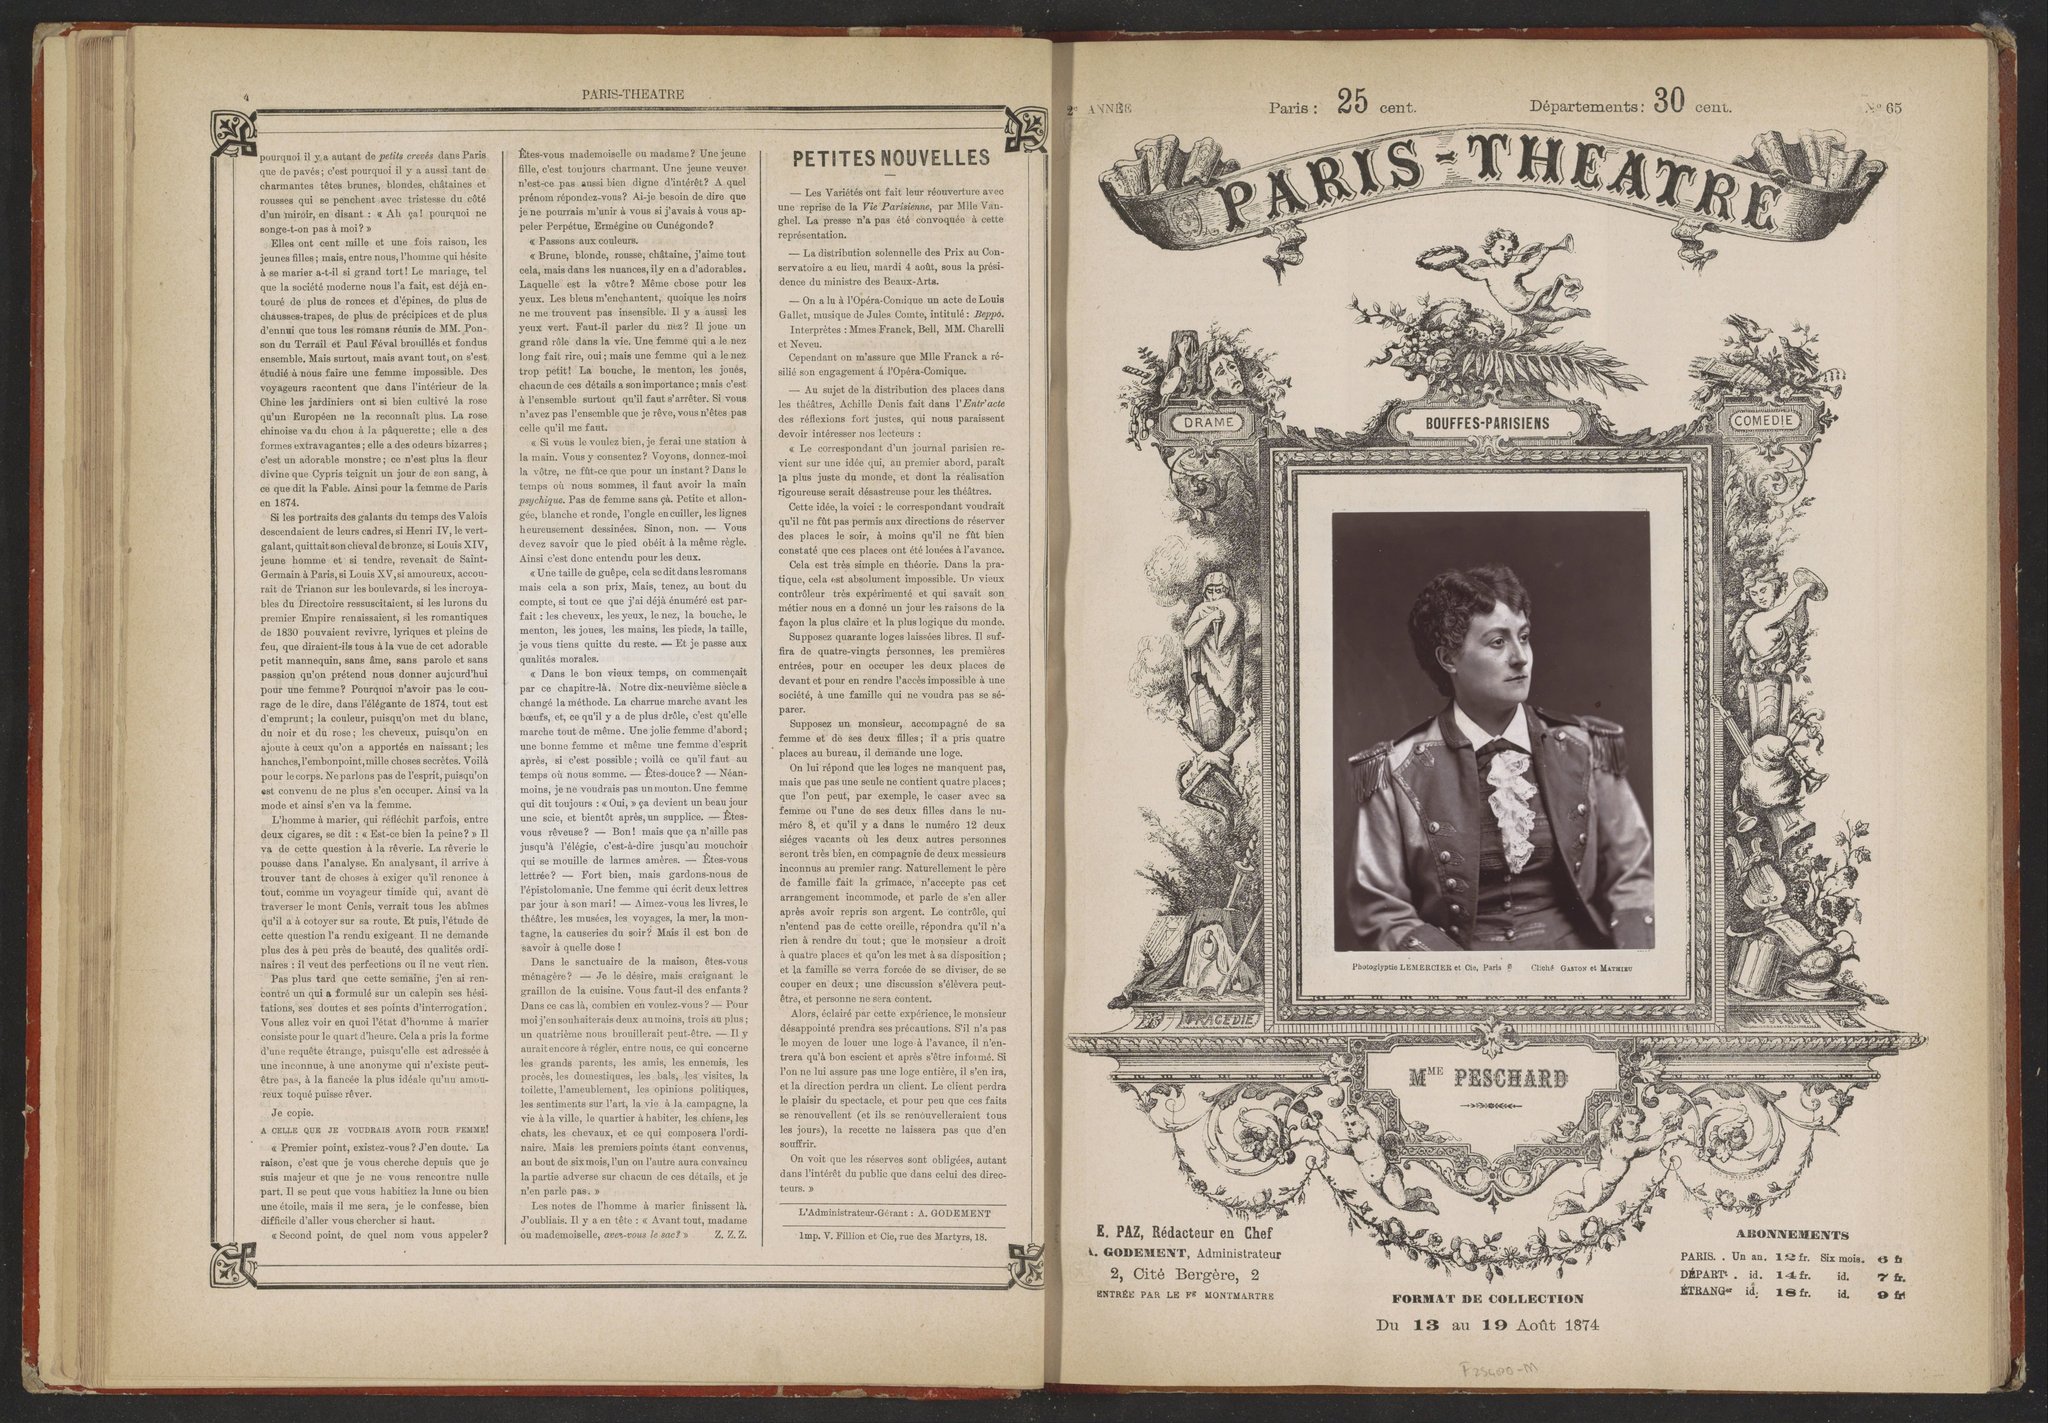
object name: photomechanical print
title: Mme Peschard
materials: paper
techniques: woodburytype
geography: france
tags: portrait of opera-singer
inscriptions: inscription: ‘Du 13 au 19 Août 1874’, number: ‘No 65’